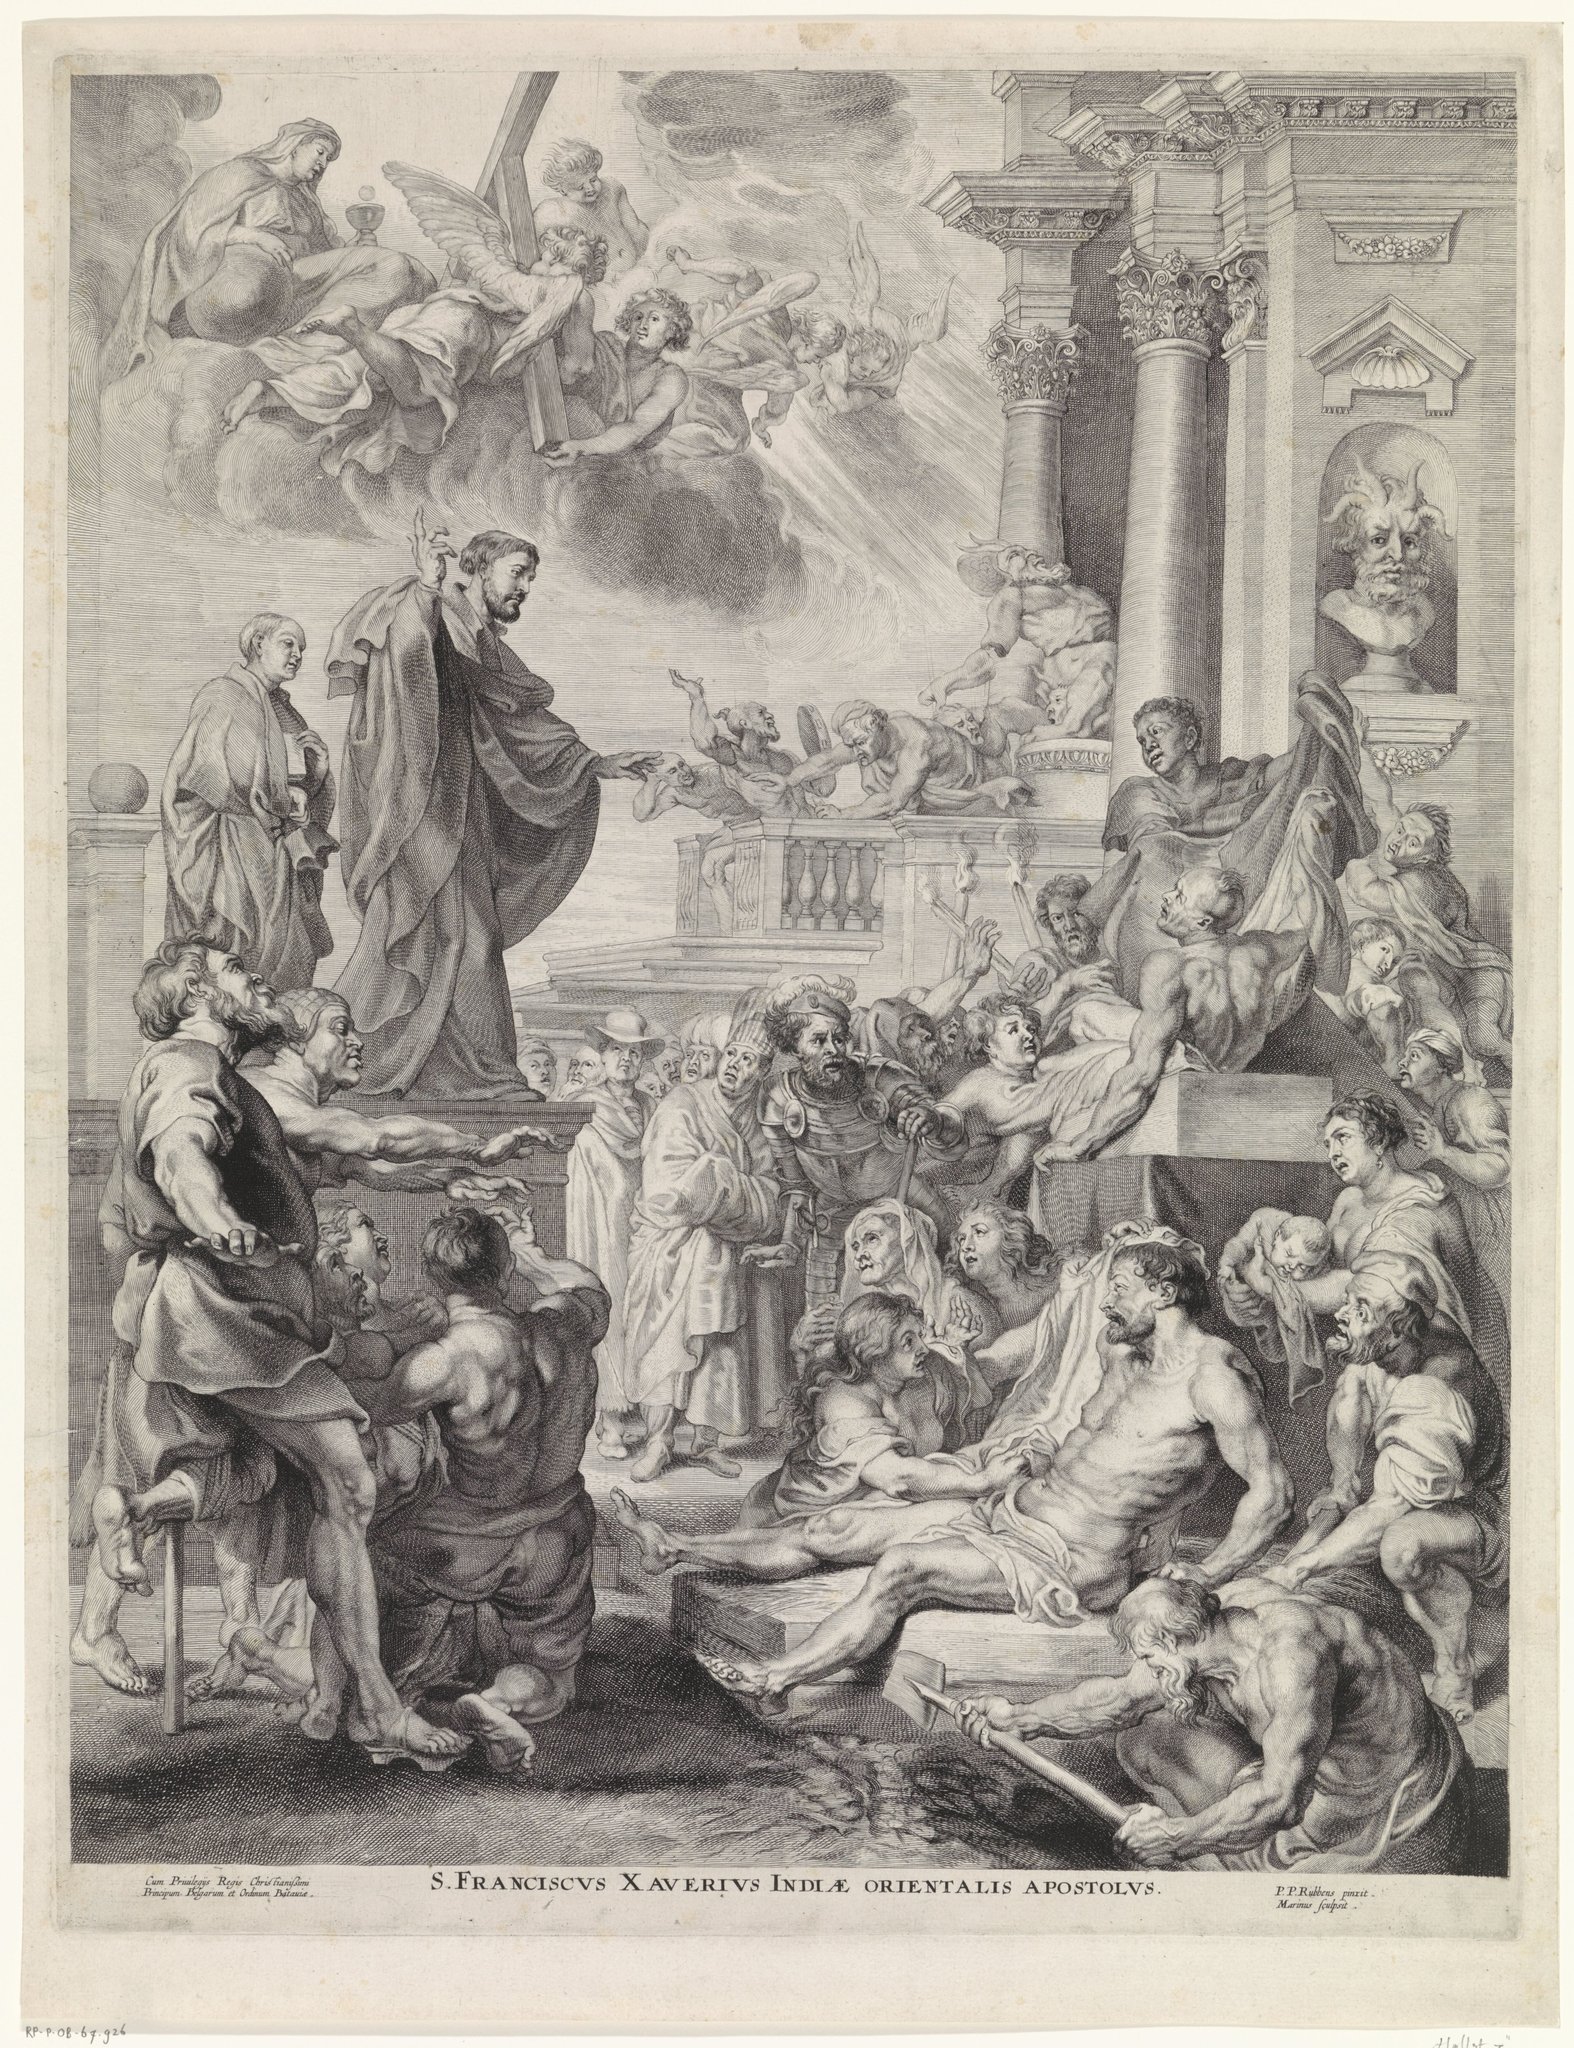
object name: print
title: S. Franciscus Xavierivs Indiae orientalis Apostolvs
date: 1630-1639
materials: paper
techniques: engraving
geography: antwerp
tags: st. francis xavier as missionary in the east indies performing miracles, disabilities, deformations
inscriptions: collector's mark: Lugt 240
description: De heilige Franciscus Xaverius wekt een dode tot leven, die opstaat uit zijn sarcofaag. Hij wordt omringd door mensen die om genezing vragen.